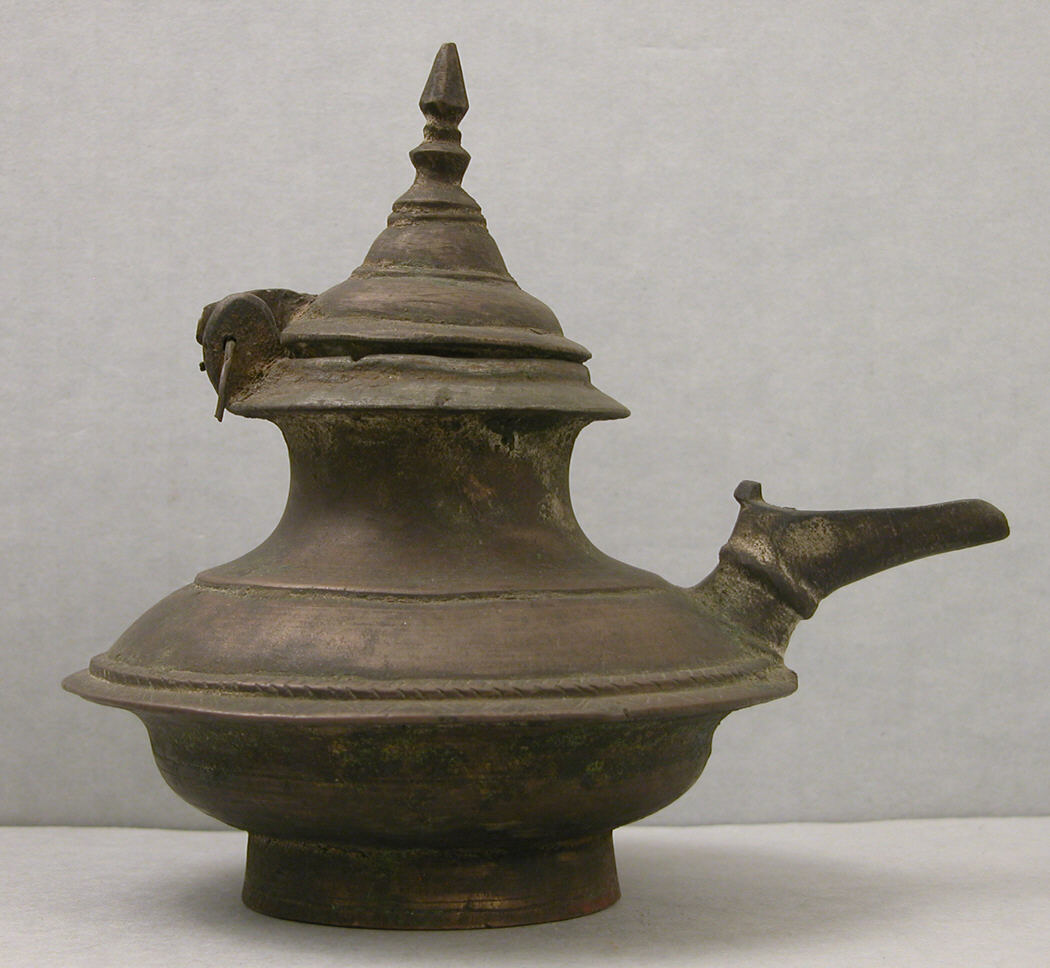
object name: ewer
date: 1601-1800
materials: bronze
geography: india